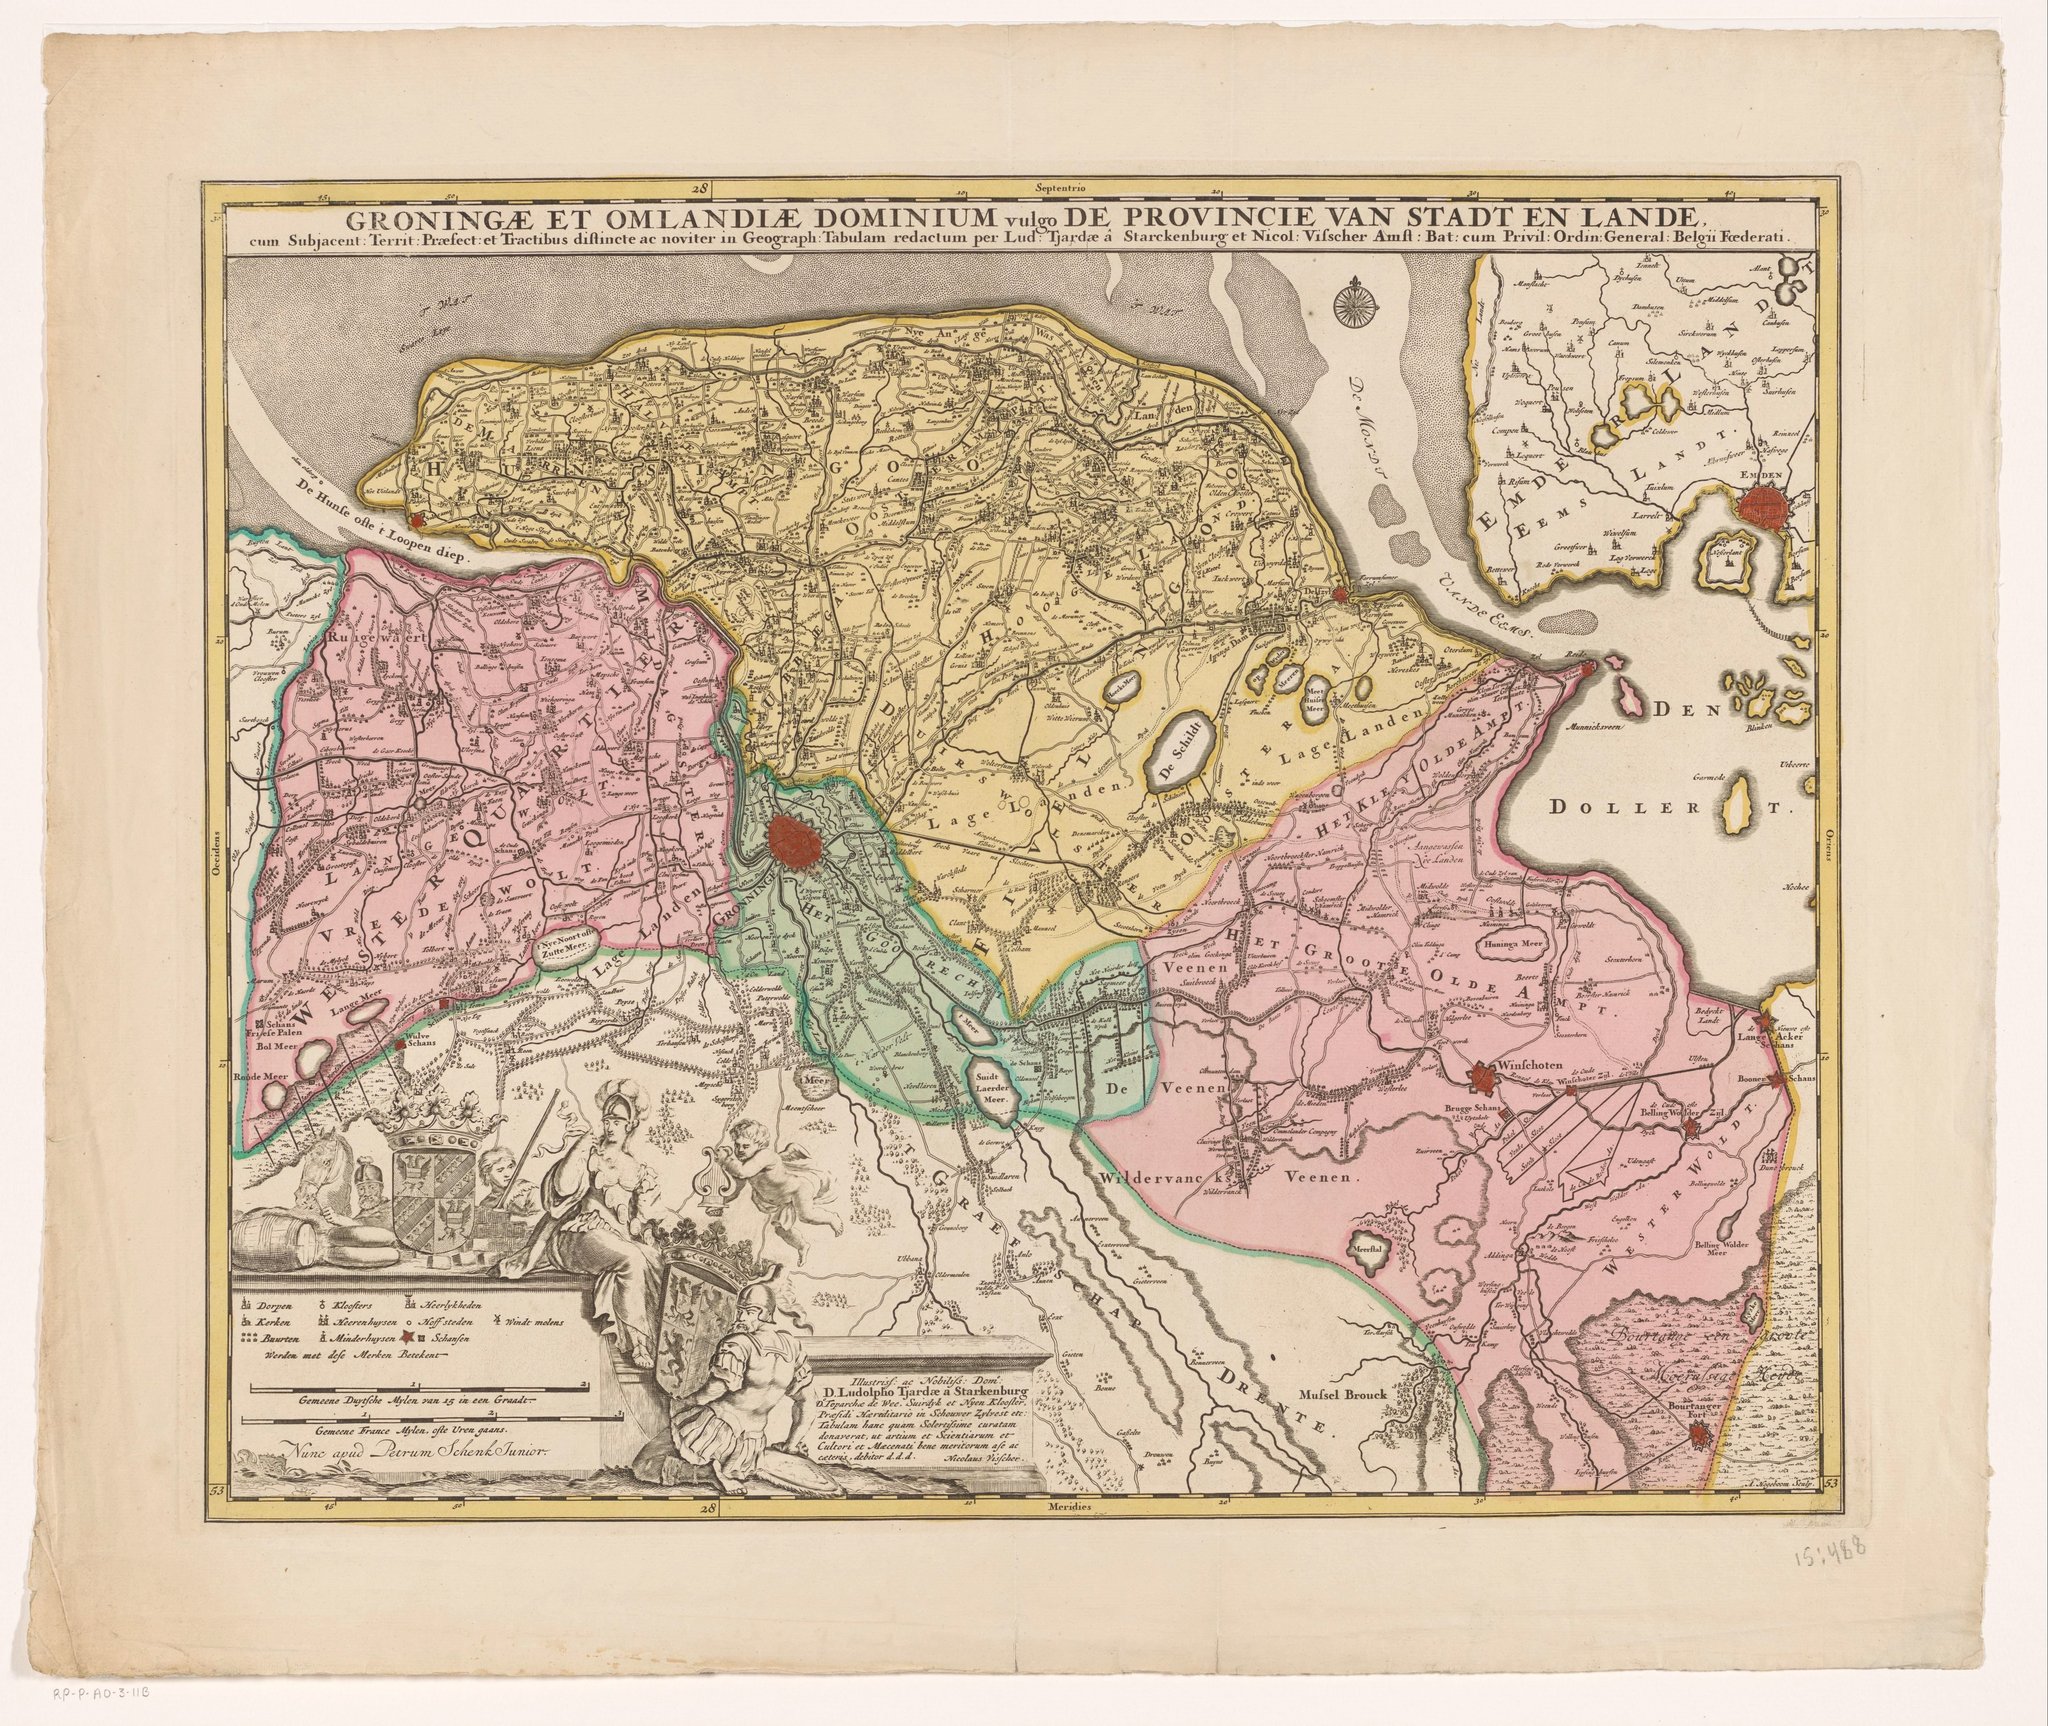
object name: map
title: Groningae et Omlandiae dominium vulgo de provincie van Stadt en Lande …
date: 1719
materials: paper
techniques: engraving, etching, hand coloring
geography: amsterdam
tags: peat (soil type), coat of arms (as symbol of the state, etc.), (story of) mars (ares), maps of separate countries or regions, (story of) minerva (pallas, athena), cheese, groningen (province)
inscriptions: collector's mark: Lugt 2228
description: Kaart van de provincie Groningen op een schaal van 1:128.000. Linksonder een cartouche met de legenda en twee schaalstokken: Gemeene Duytsche mylen van 15 in een graadt, Gemeene France mylen ofte uren gaans. Daarboven het wapen van Groningen, rechts ervan het wapen van Ludolph Tjarda van Starkenburg onder een putto met harp, geflankeerd door een gehelmde vrouw en man (mogelijk Minerva en Mars). Om het Groningse wapen kazen, turf, een houten vat, een paard en twee mannen. Gradenverdeling langs de randen.